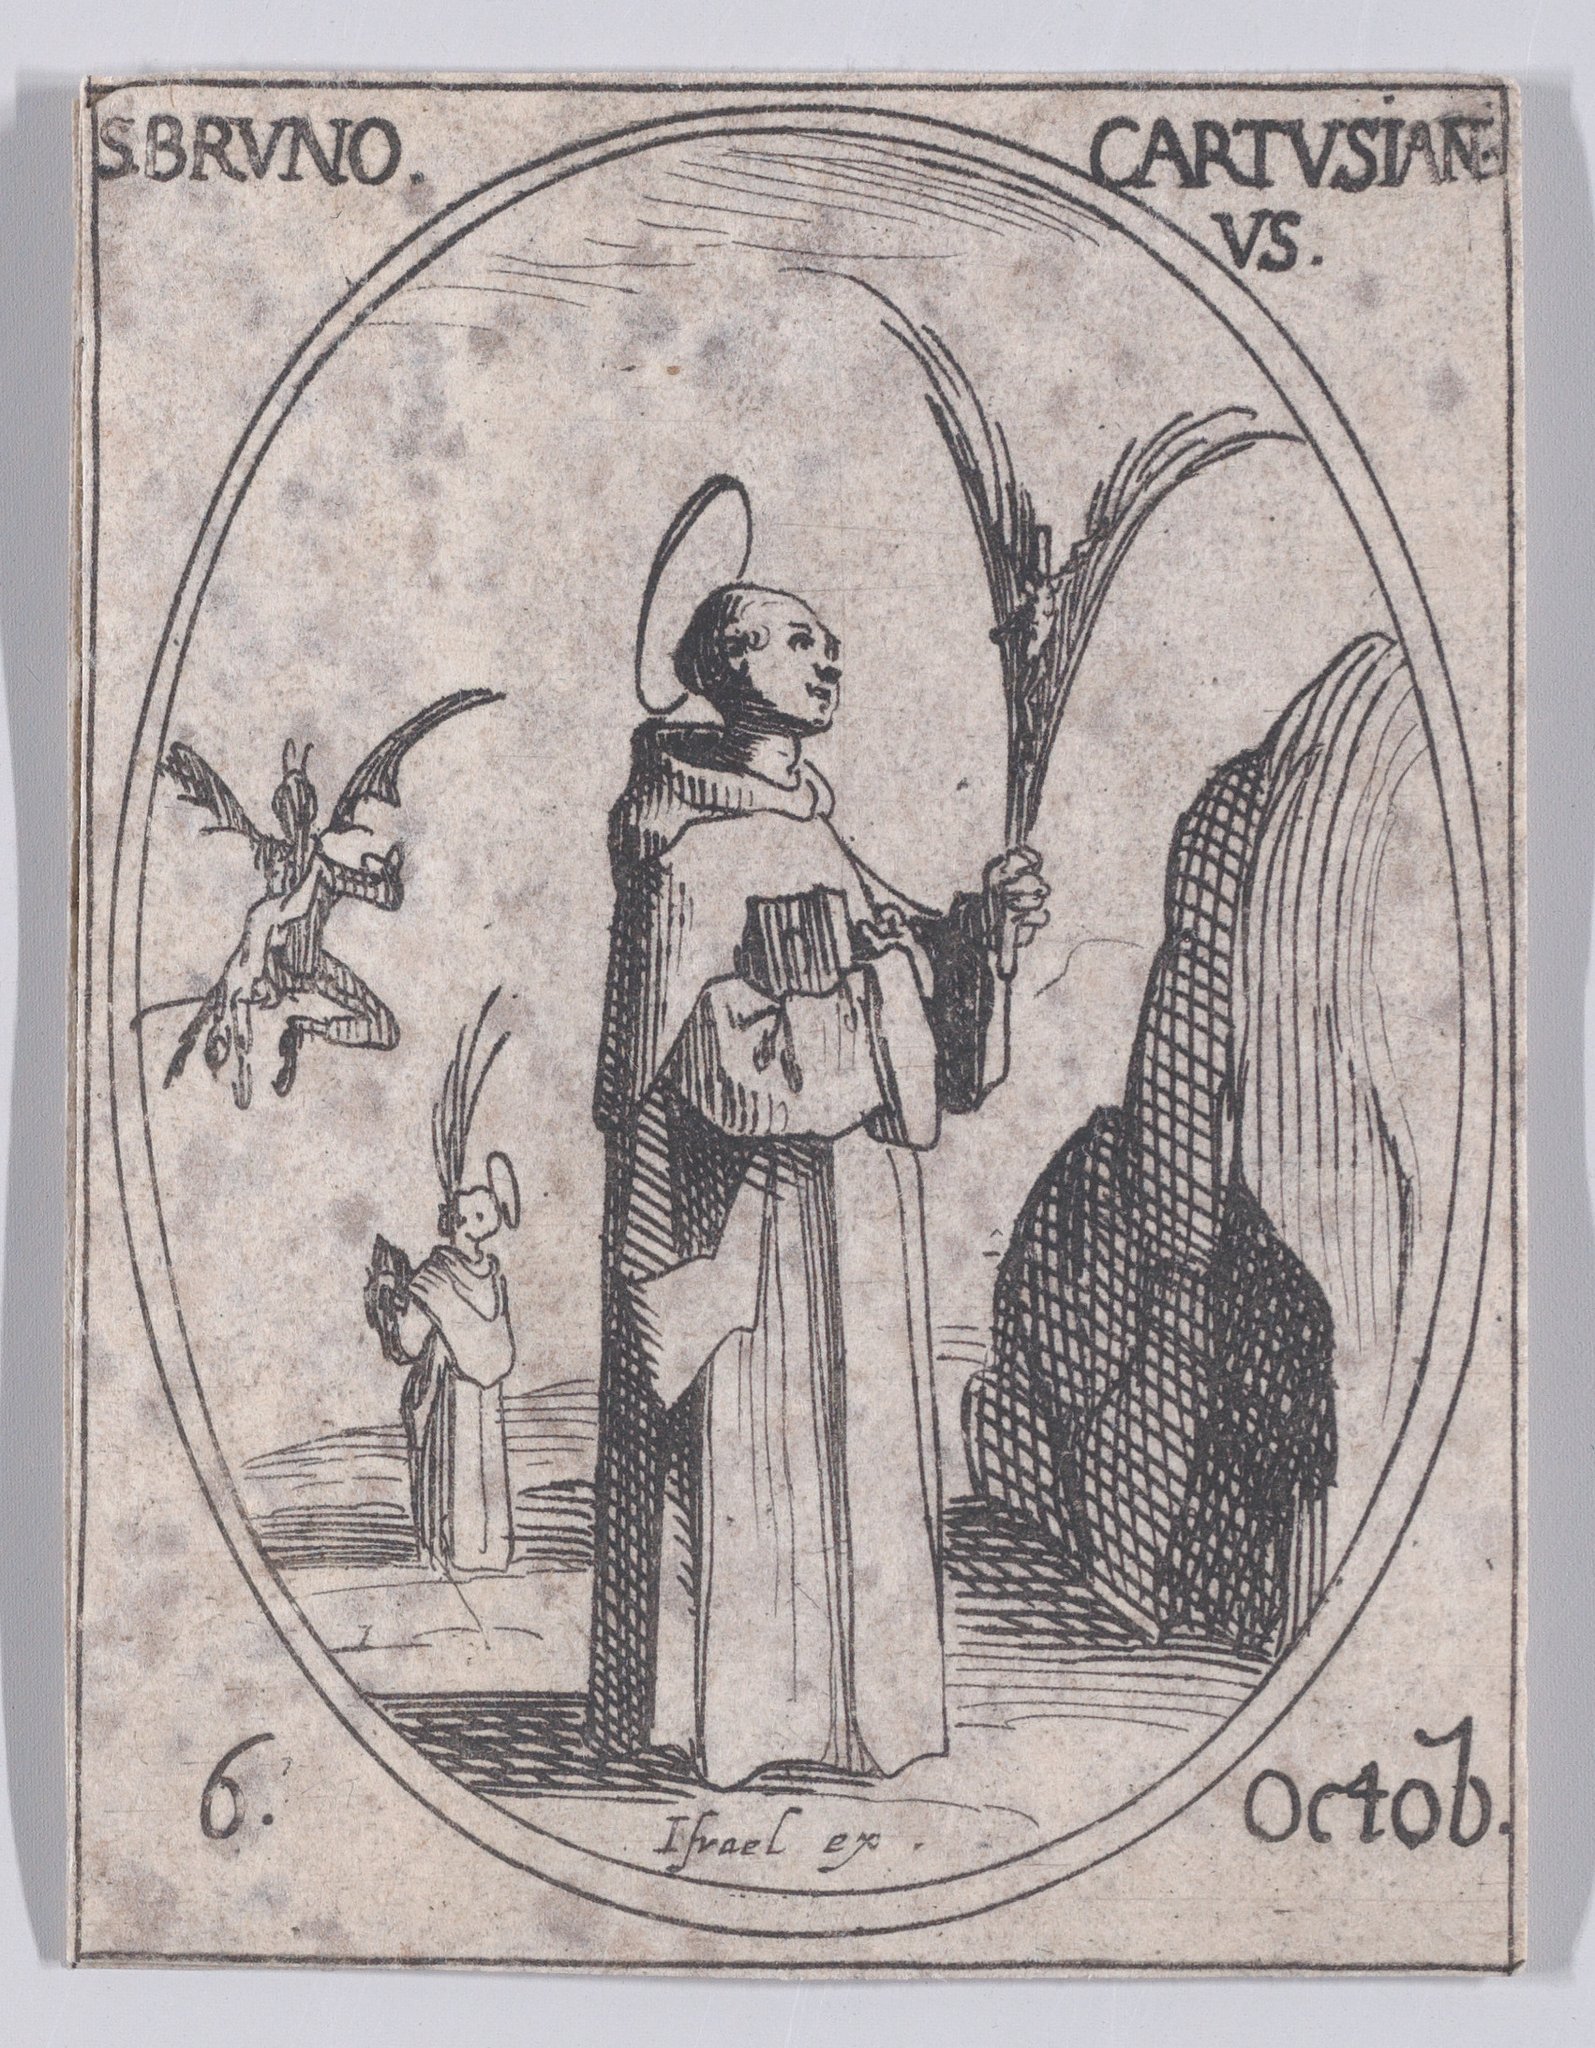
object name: print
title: S. Bruno, chartreux (St. Bruno, Carthusian Monk), October 6th, from "Les Images De Tous Les Saincts et Saintes de L'Année" (Images of All of the Saints and Religious Events of the Year)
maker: jacques callot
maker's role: artist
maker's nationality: french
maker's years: 1592-1635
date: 1636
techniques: etching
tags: men,saints